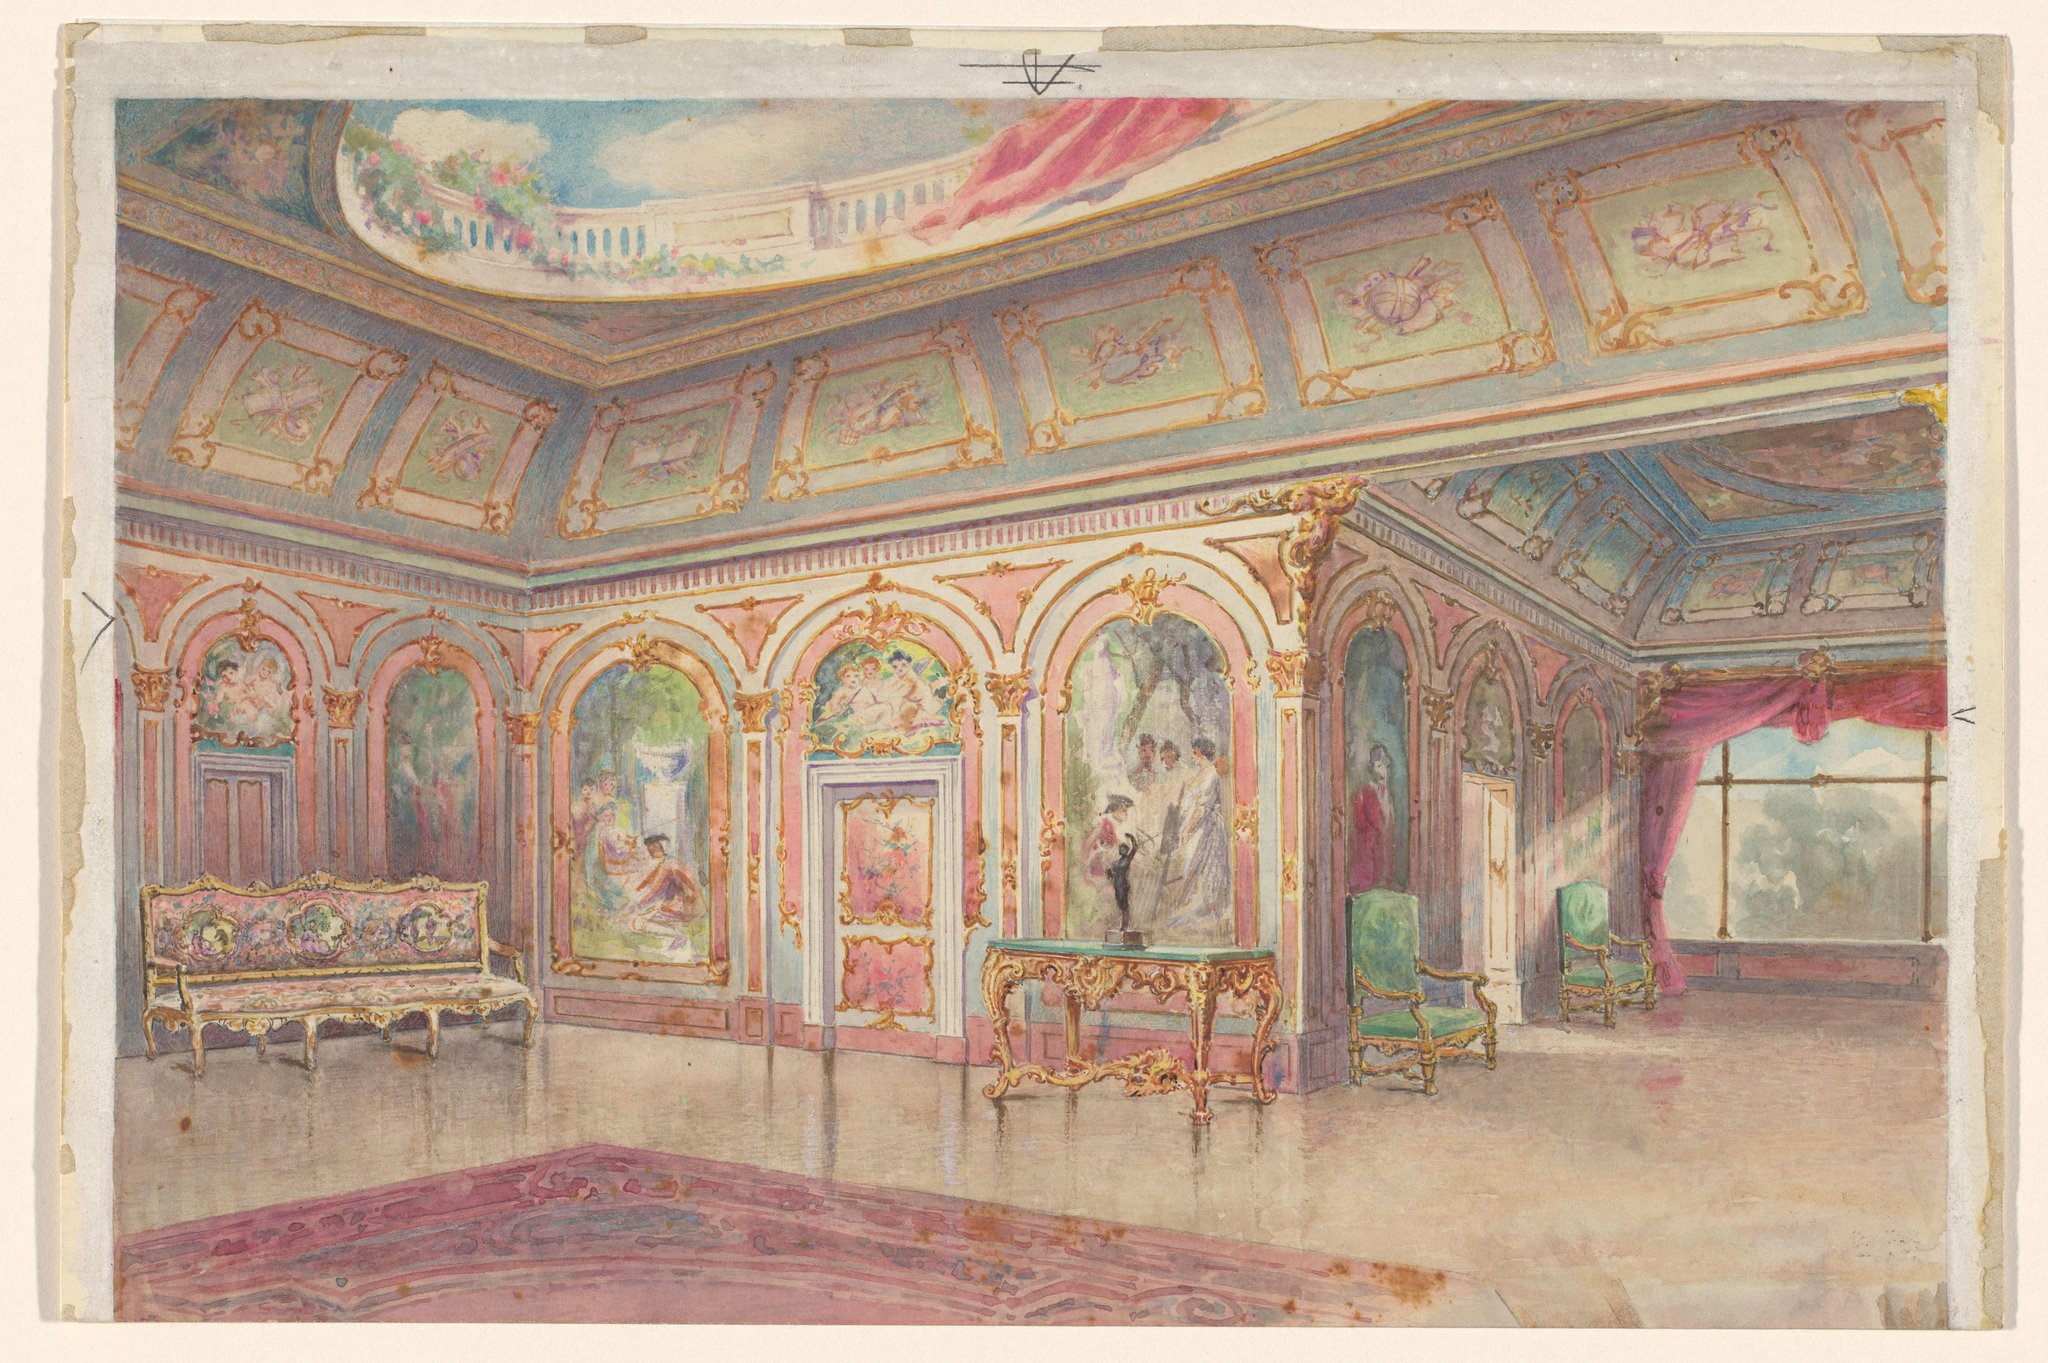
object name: design drawing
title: Een interieur in neo-rococo stijl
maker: Anonymous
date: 1900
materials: paper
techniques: aquarelle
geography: germany